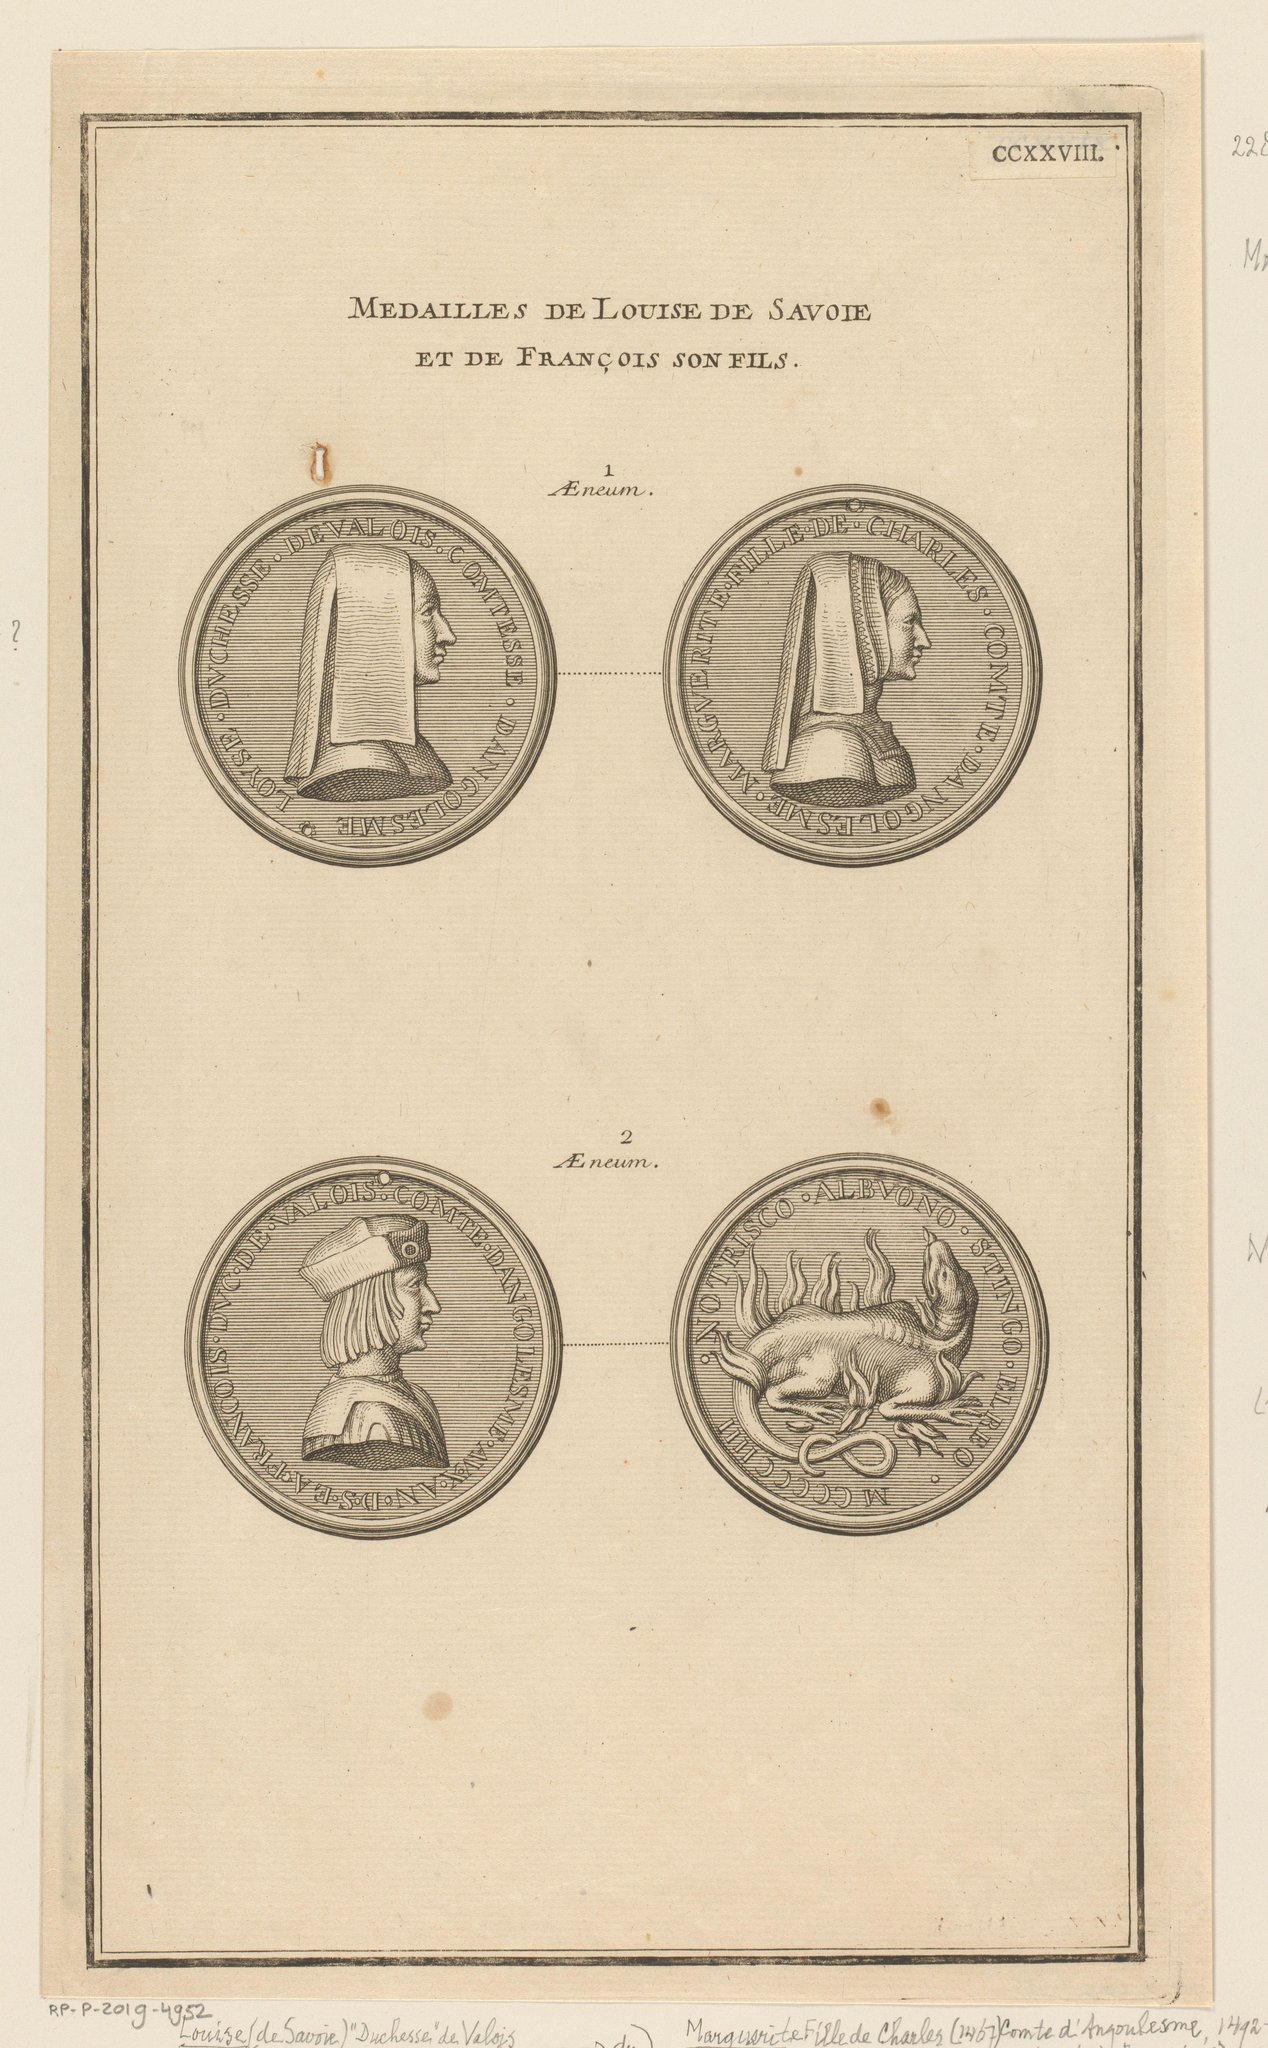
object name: book illustration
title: Penningen met portretten van Louise van Savoye, Margaretha van Valois en Frans I, koning van Frankrijk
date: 1750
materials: paper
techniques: etching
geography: london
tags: frans i van valois-angoulême (koning van frankrijk), historical persons - bb - woman, historical persons, medal (considered as a piece of sculpture, regardless of its specific function), king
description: Prent uit: Montfaucon, Bernard de. A collection of regal and ecclesiastical antiquities of France (...). Londen: William Innys, John en Paul Knapton, R. Manby en Henry Shute Cox, 1750, dl. 2. Prent voor het eerst, met andere nummering, verschenen in: Montfaucon, Bernard de. Les monumens de la Monarchie Françoise (...). Parijs: Julien-Michel Gandouin en Pierre-François Giffart, 1729-1733.